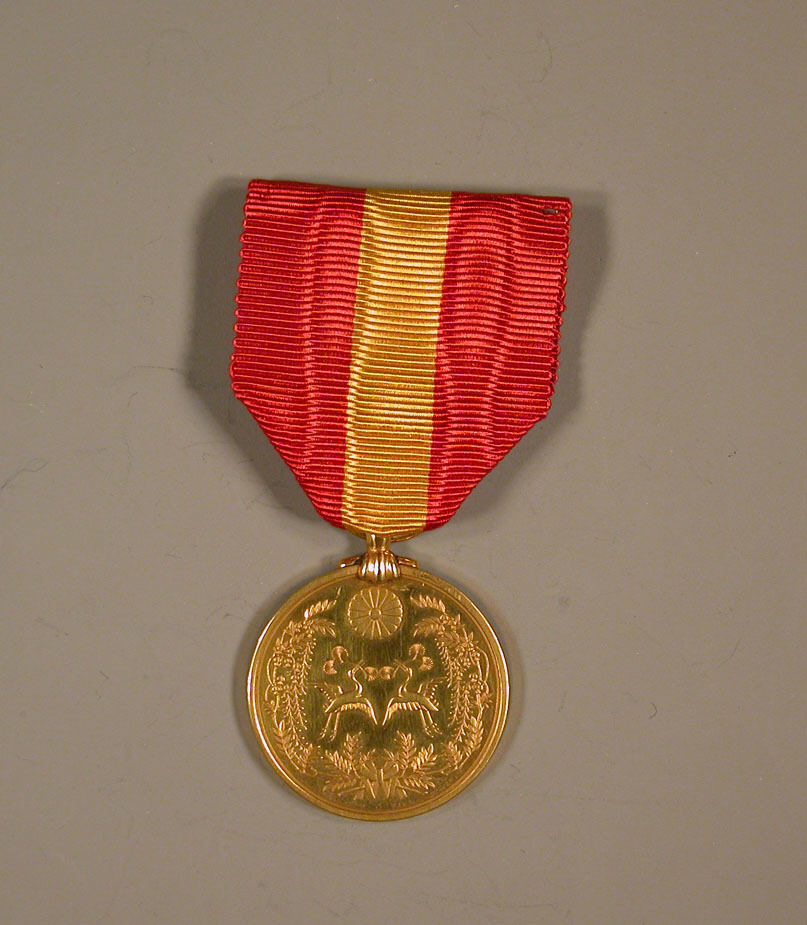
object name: medal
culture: japanese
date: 1867-1900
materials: gold, ribbon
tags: emblems